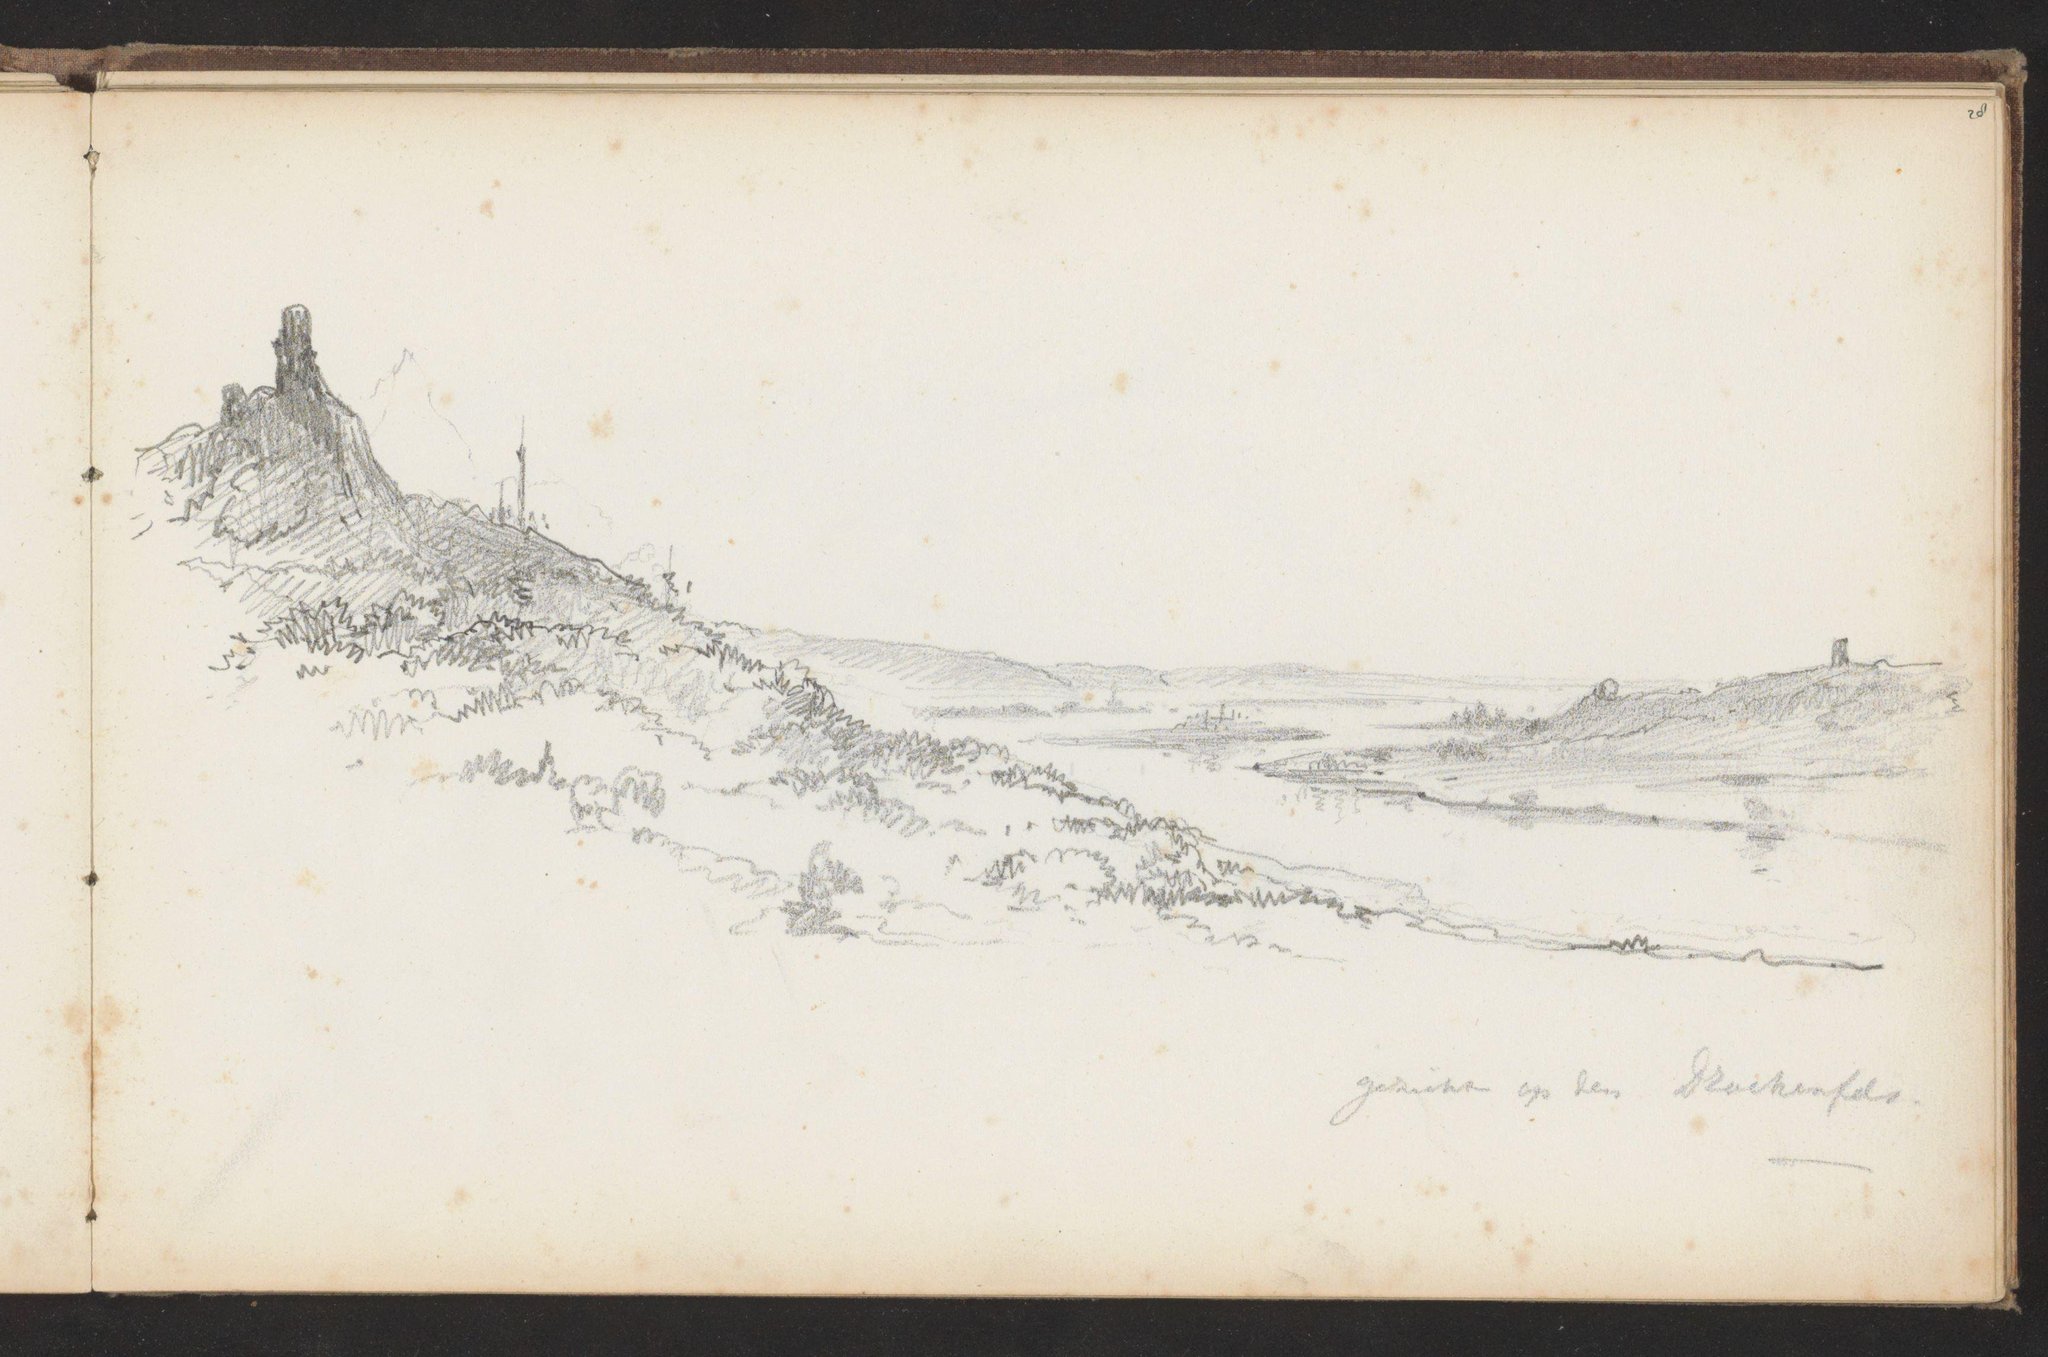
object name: sketchbook leaf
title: Gezicht op Drachenfels aan de Rijn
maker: maria vos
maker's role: draughtsman, painter, print maker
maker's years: 1824-1906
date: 1860-1865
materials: paper, pencil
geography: zevengebergte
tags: landscapes with waters, waterscapes, seascapes (in the temperate zone), landscape with ruins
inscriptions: annotation: ‘gezicht op den Drachenfels’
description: Blad 28 recto uit een schetsboek met 55 bladen.